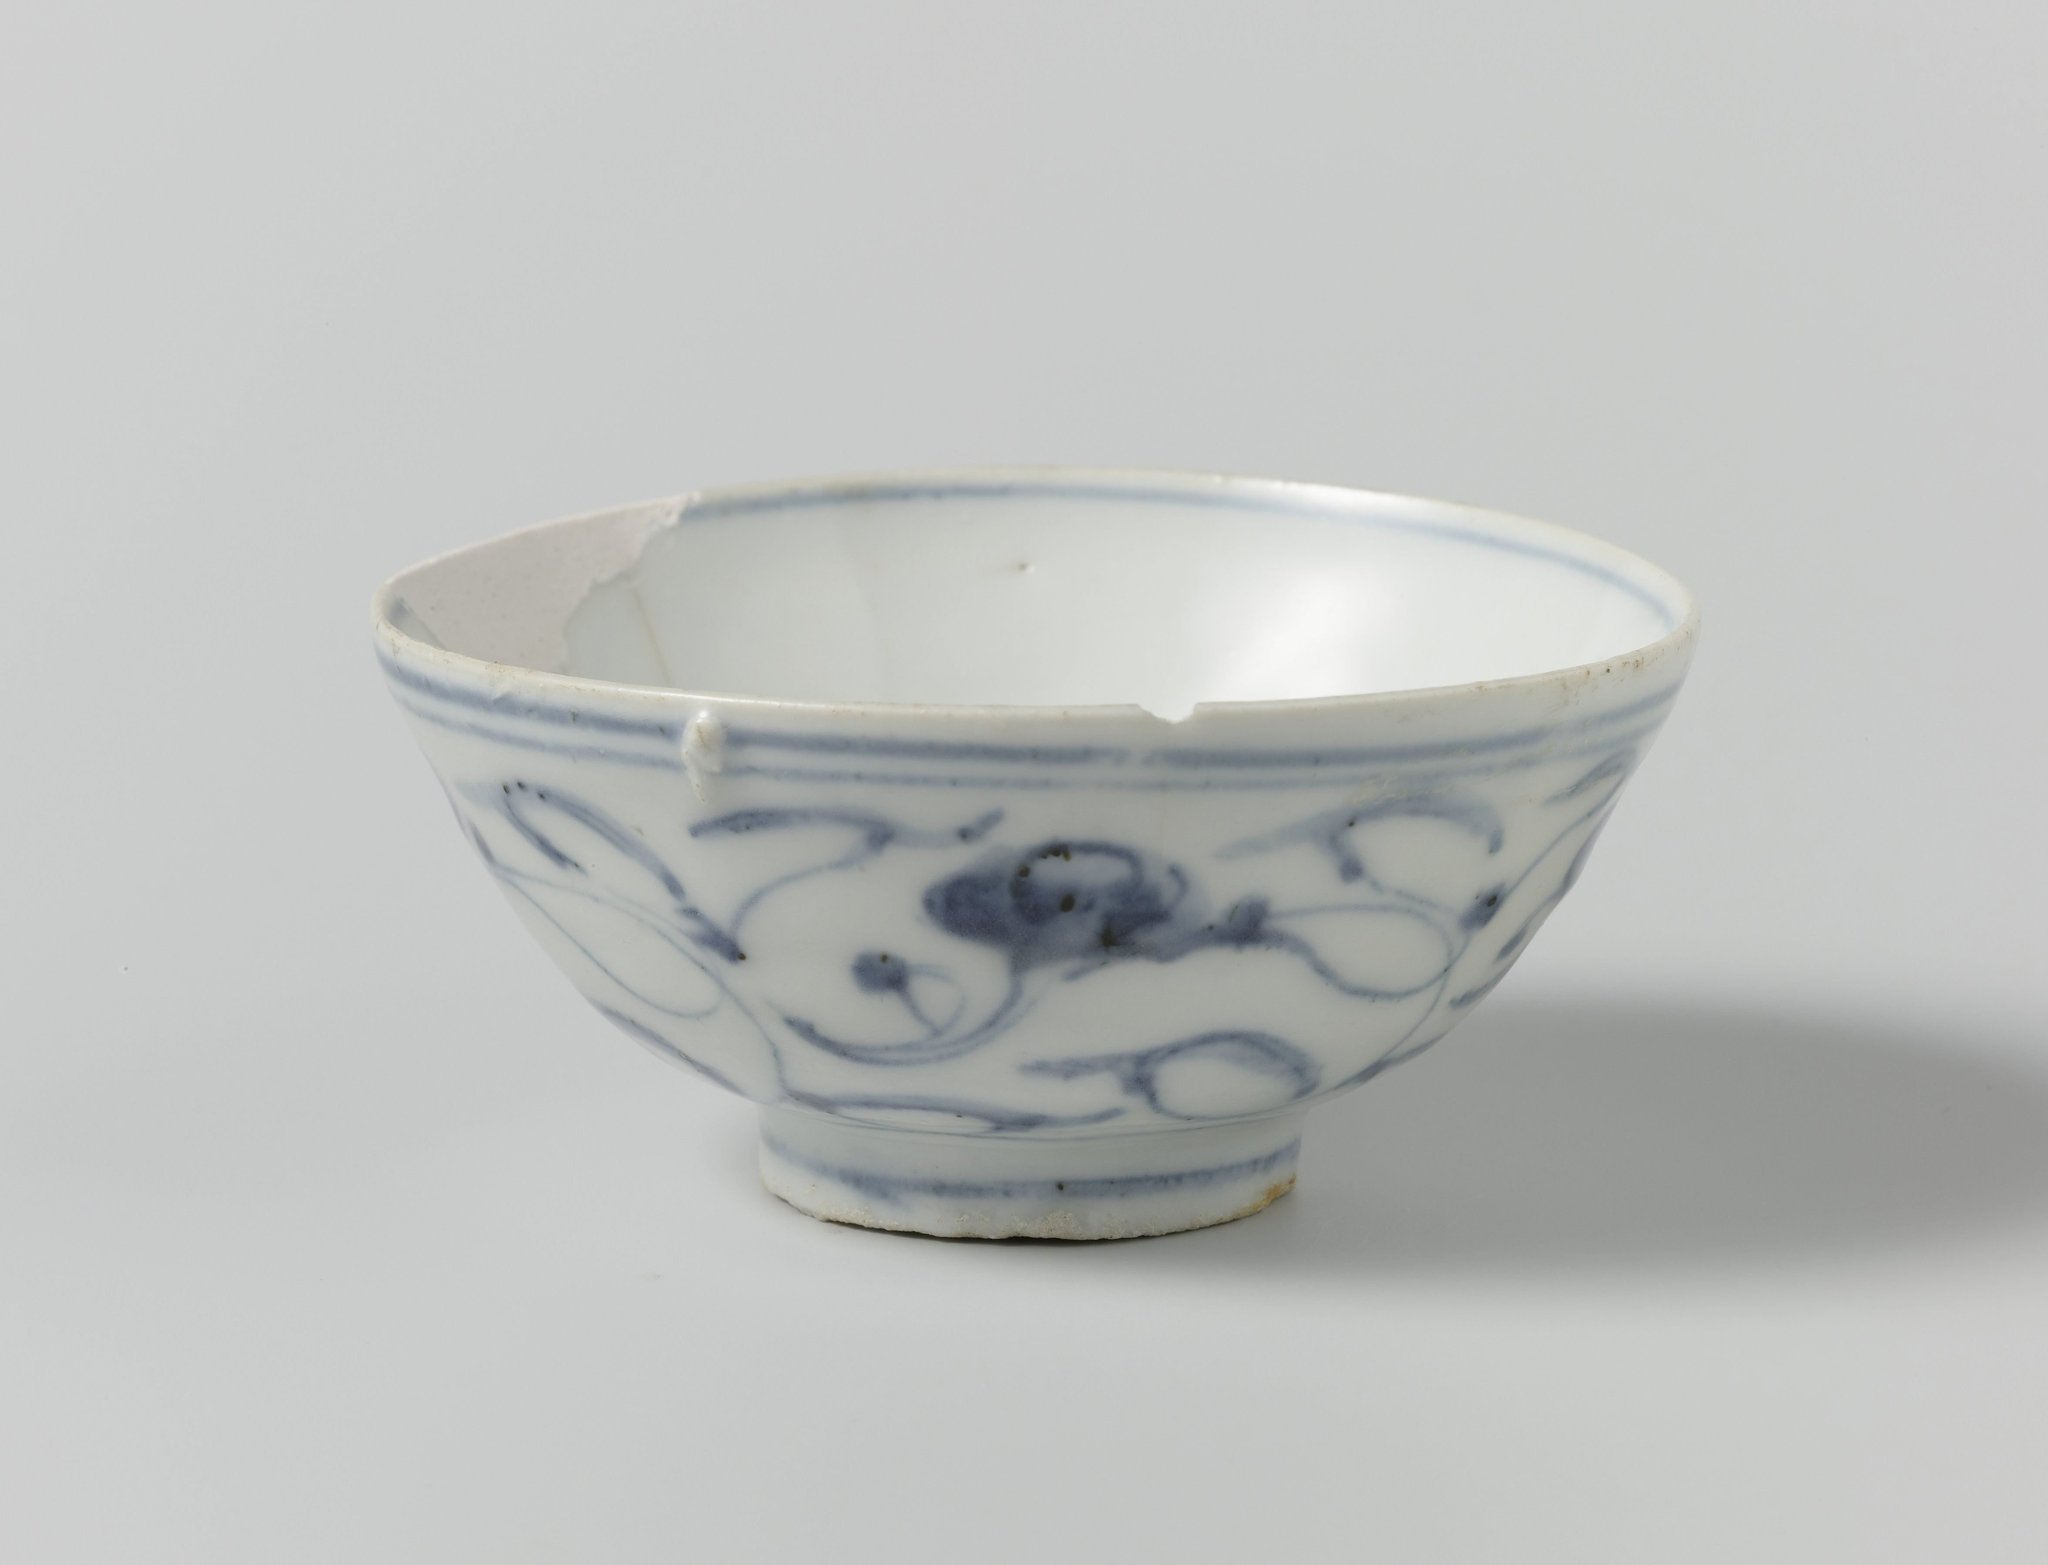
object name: bowl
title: Kom uit V.O.C.-schip de 'Witte Leeuw'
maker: Anonymous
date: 1613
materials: porcelain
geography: jingdezhen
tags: verenigde oostindische compagnie, sint-helena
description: A bowl. In the centre a simple flower is drawn encircled by a band. On the lip-rim a band is also drawn. On the outside a continuous scroll of stylized flowers is drawn very sketchily.